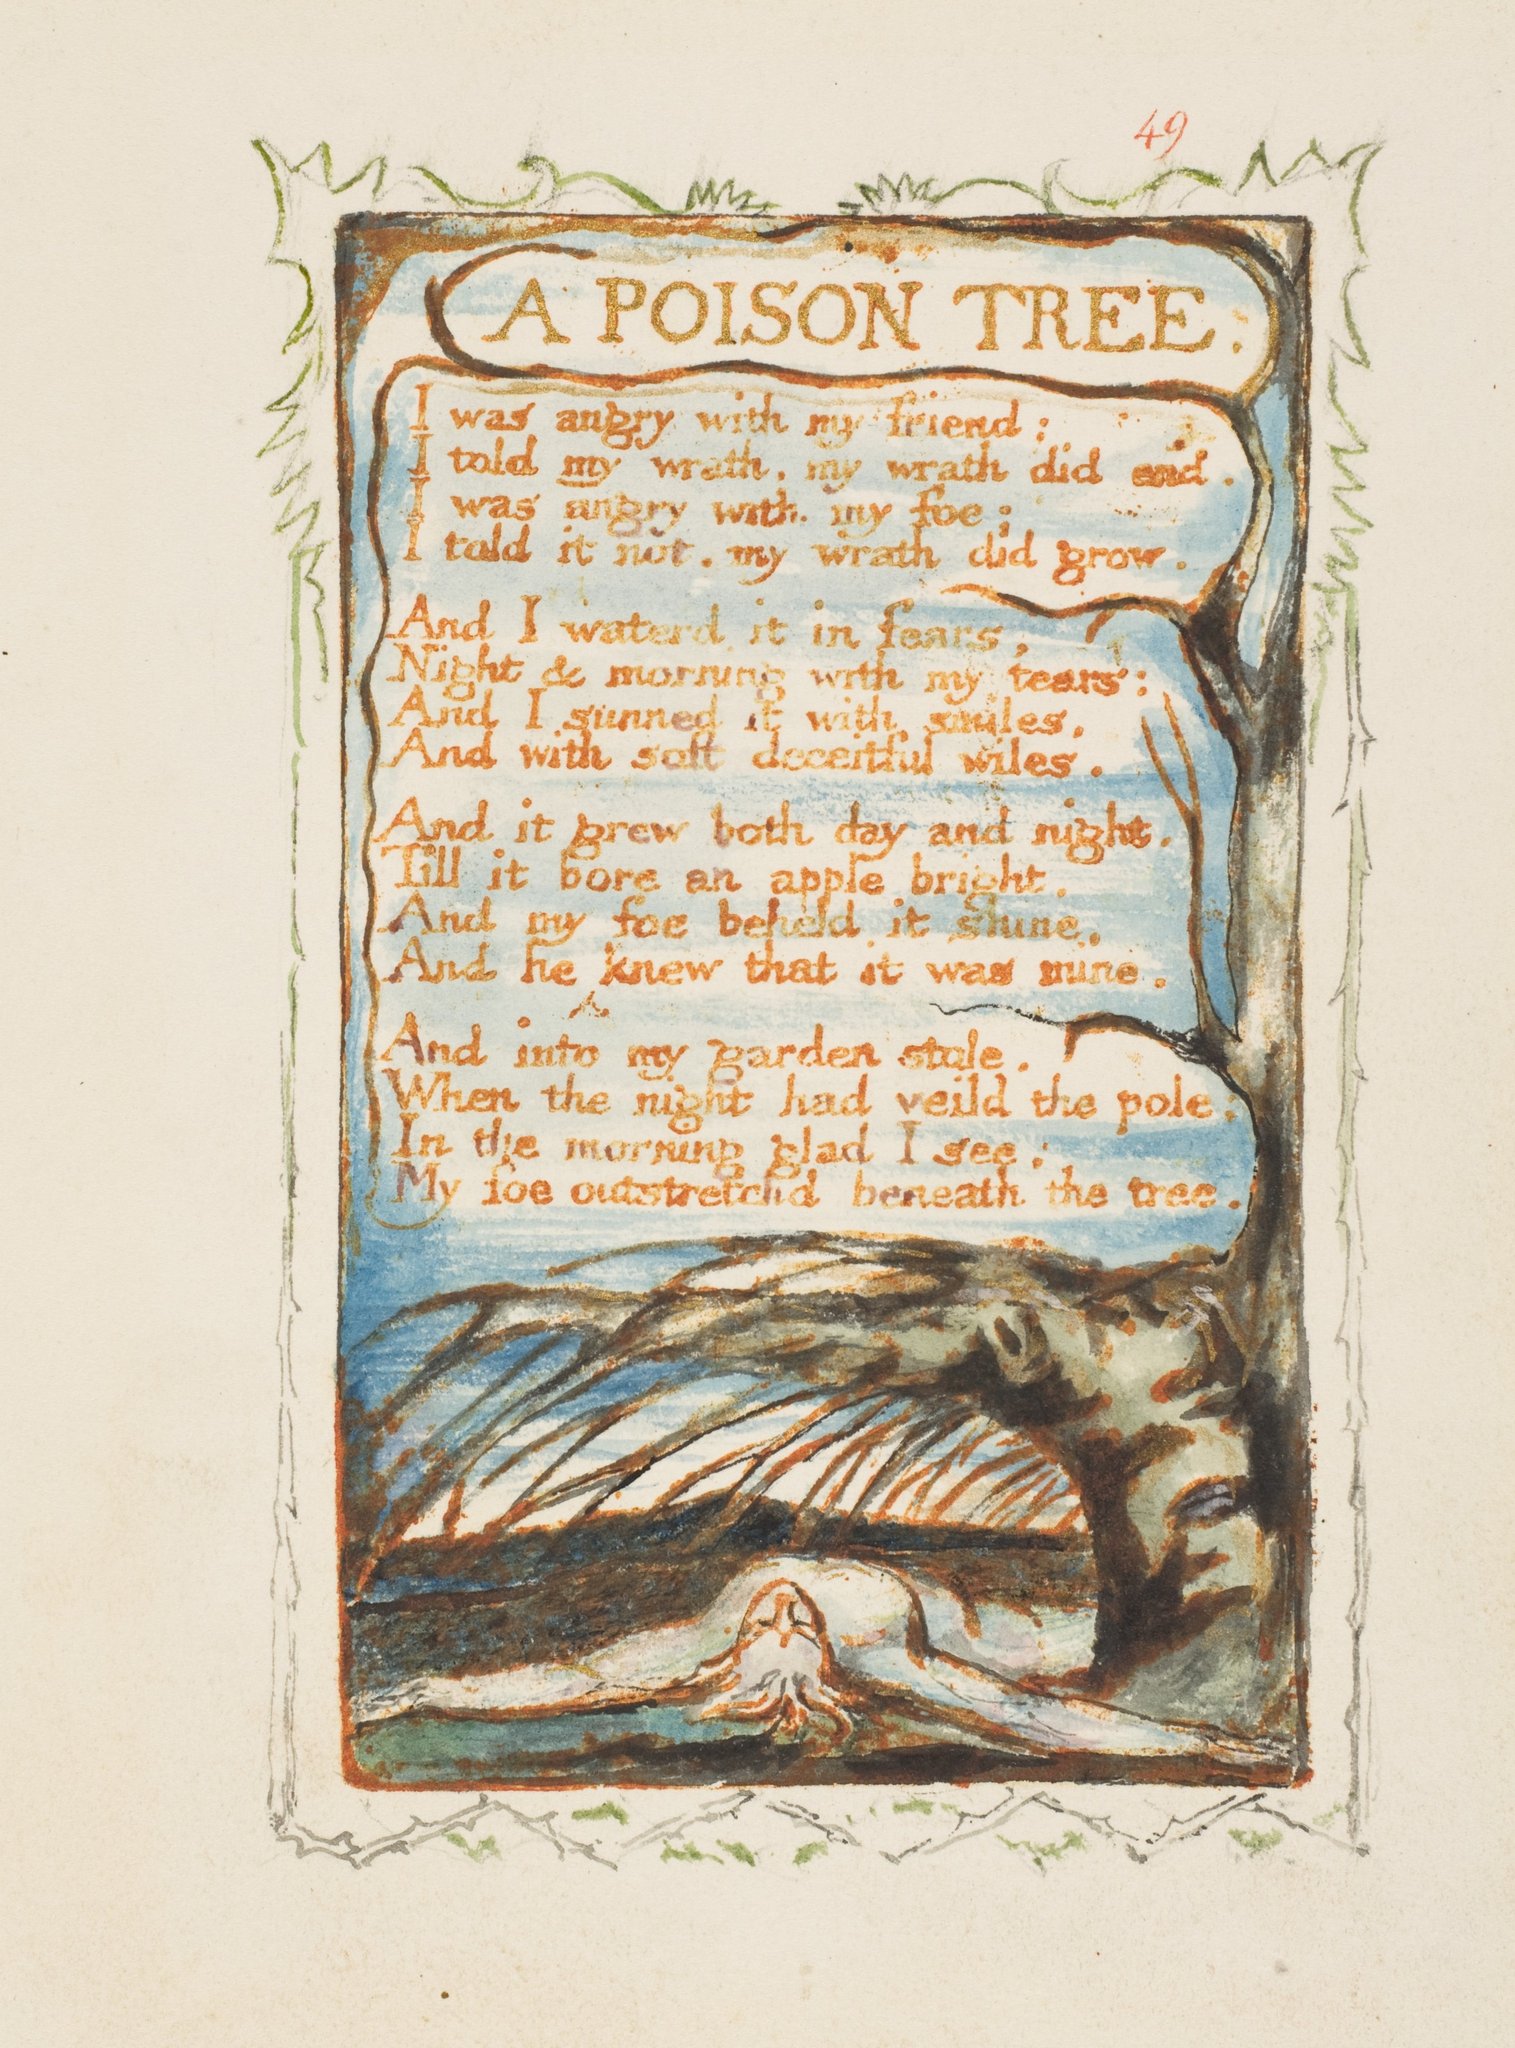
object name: print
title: Songs of Experience: A Poison Tree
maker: william blake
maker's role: artist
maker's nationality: british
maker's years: 1757-1827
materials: gold, ink, shell, watercolor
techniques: etching, hand coloring, printing, relief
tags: human figures,poetry